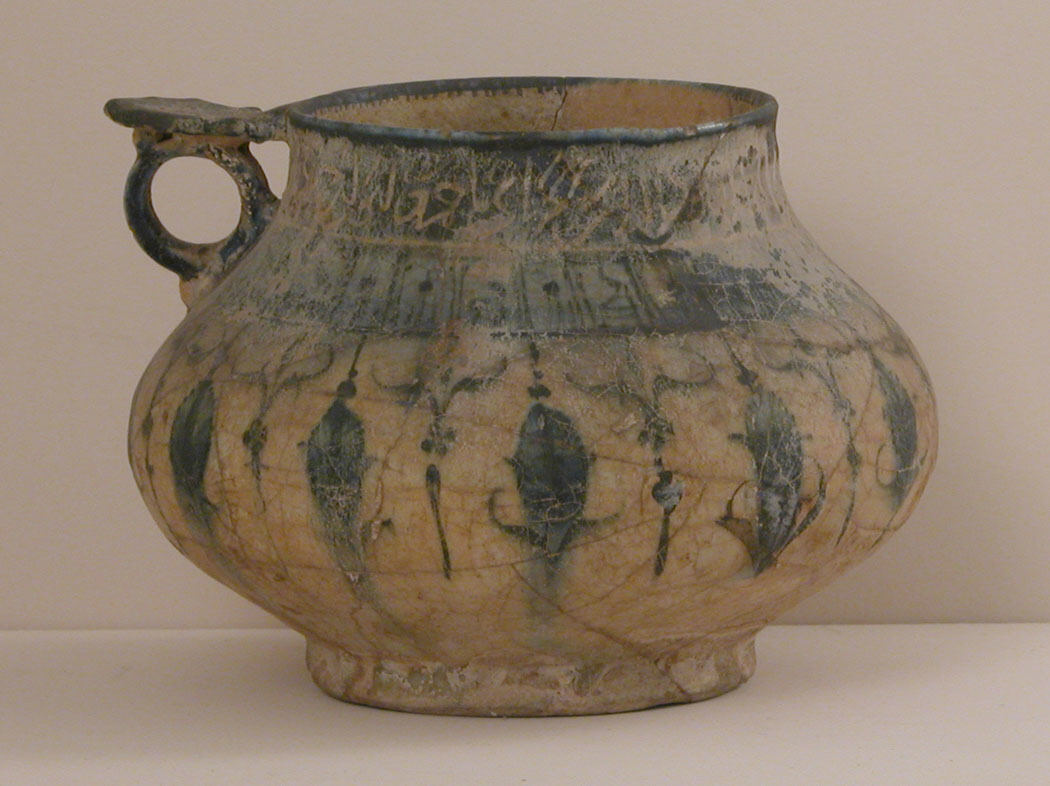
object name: ewer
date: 1201-1300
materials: stonepaste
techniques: glazing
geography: iran